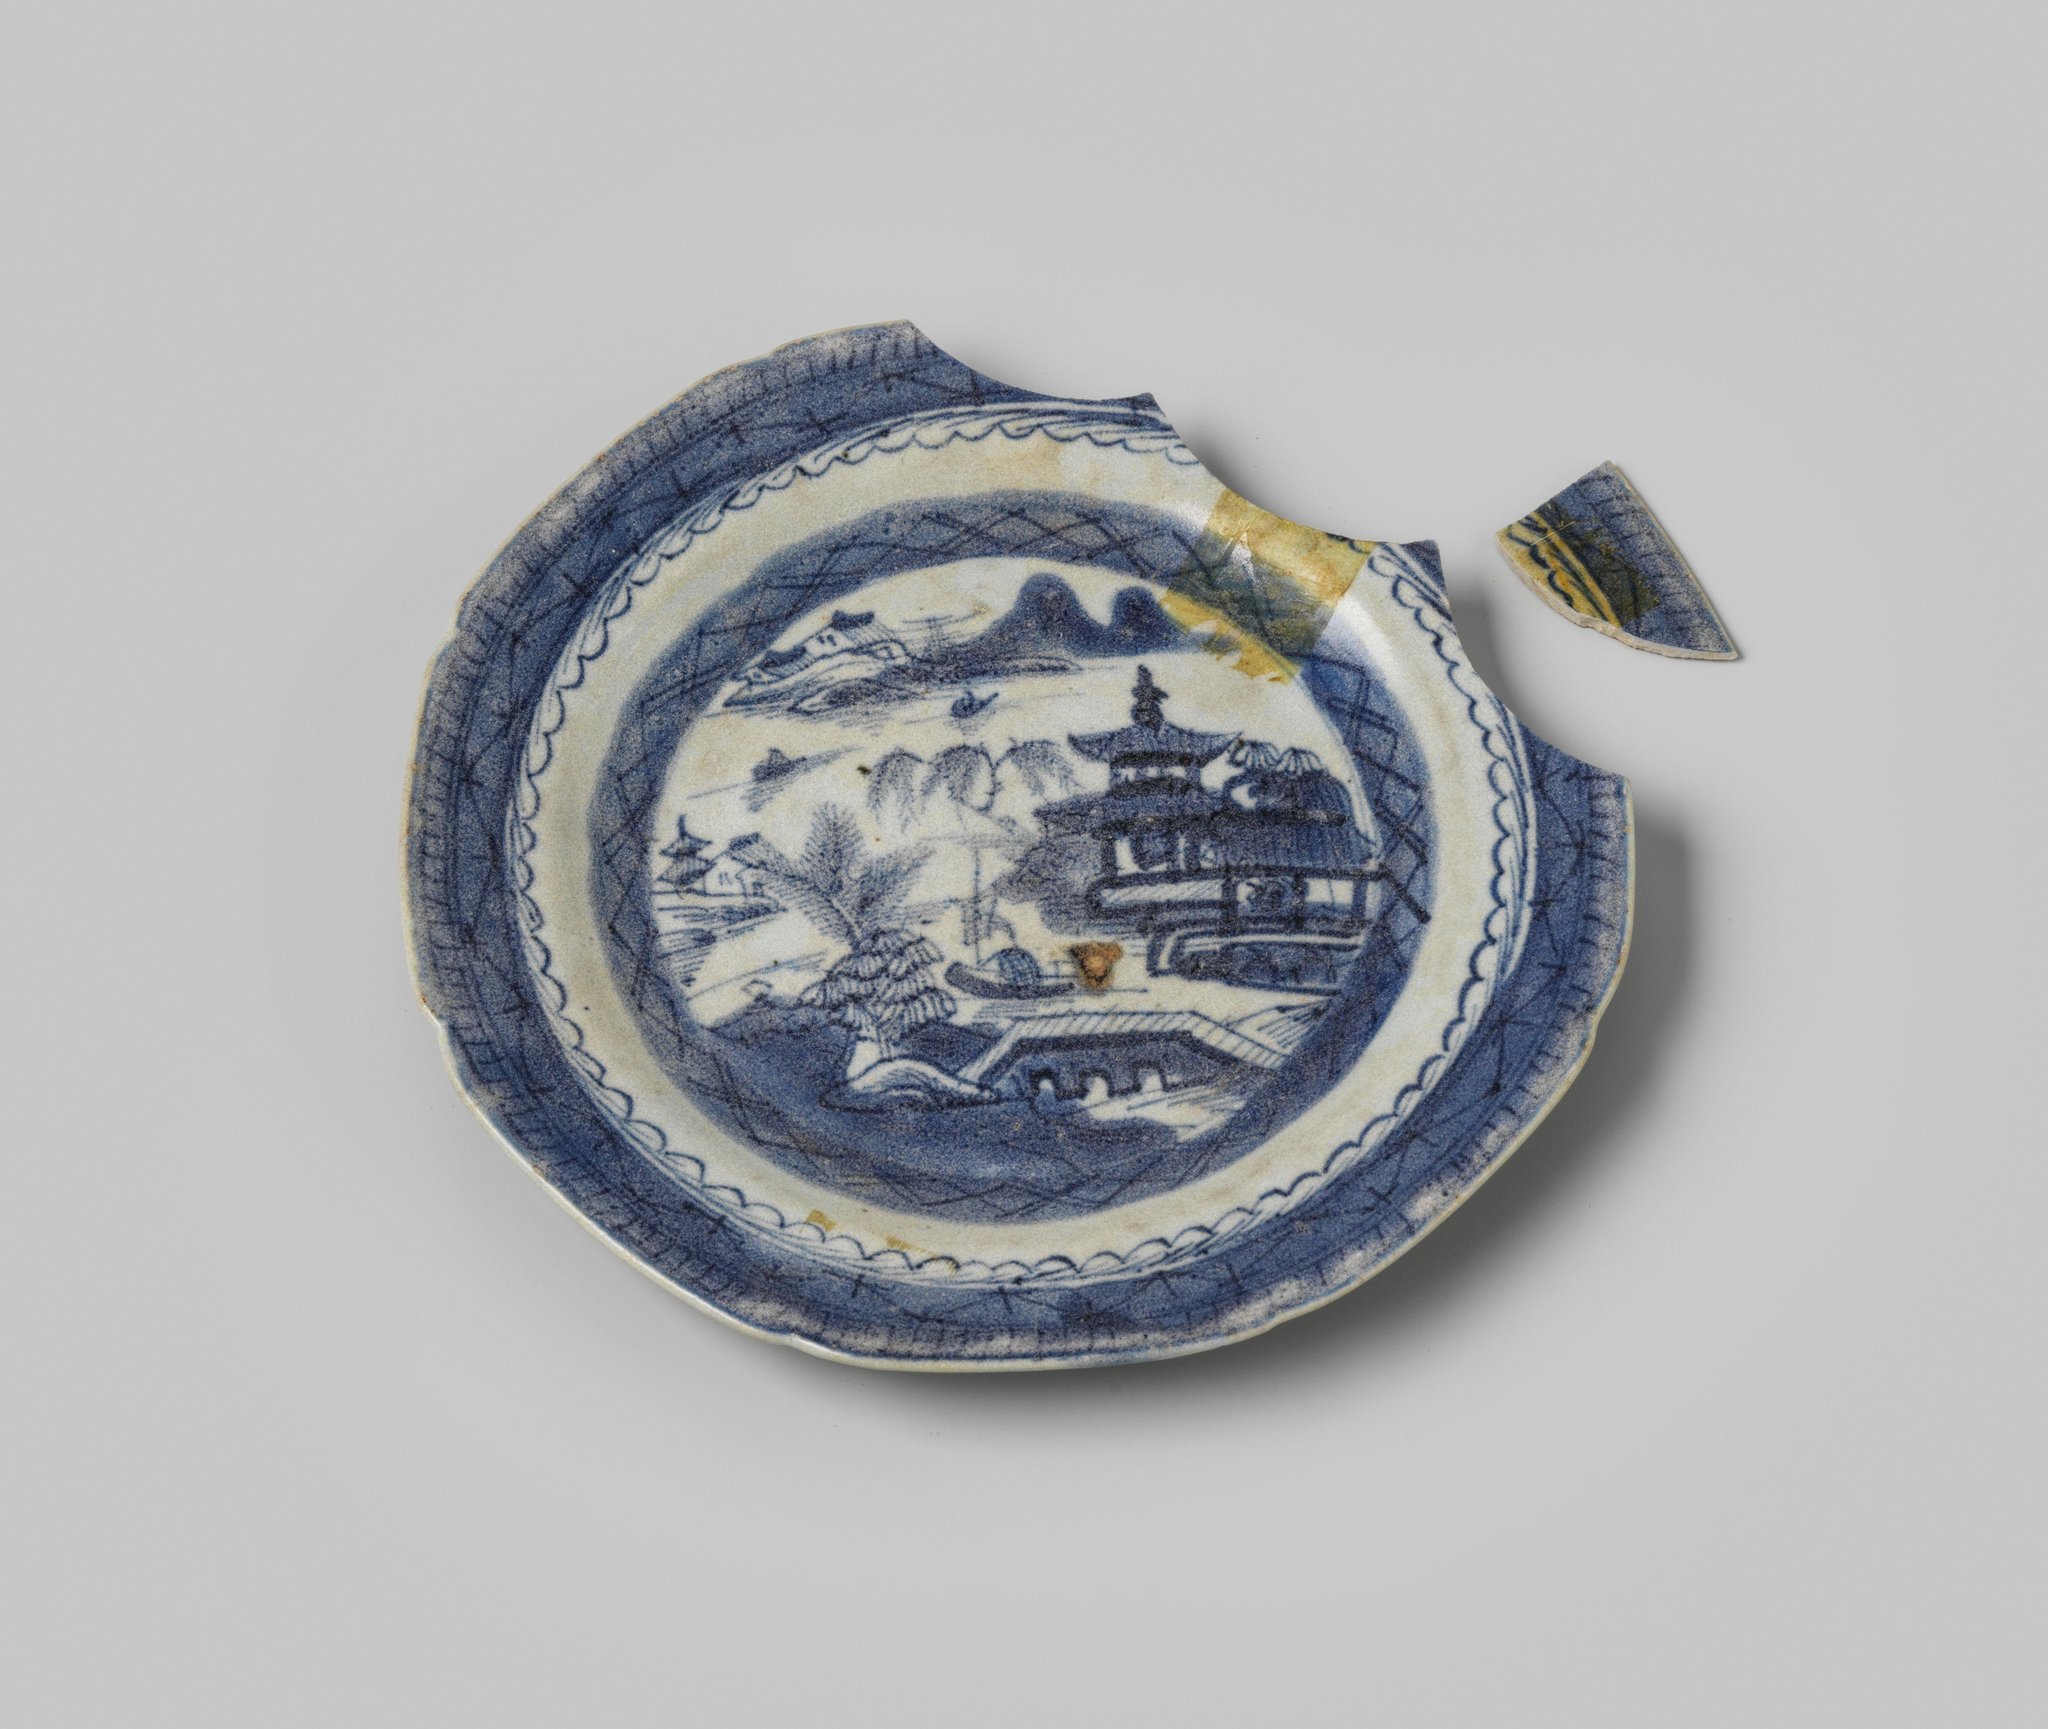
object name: plate dish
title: Bord, gevonden bij V.O.C.-schip Witte Leeuw, mogelijk afkomstig van Zeelelie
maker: Anonymous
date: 1775-1800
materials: porcelain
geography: jingdezhen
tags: verenigde oostindische compagnie, sint-helena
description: A plate. An almost complete plate with an octangular rim. The body is grey-white. The coarse, mottled purple-blue painting is under a grey-white glaze. A central decoration of a willow pattern with a bridge surrounded by a so-called Cantonborder. The same border is repeated on the rim.